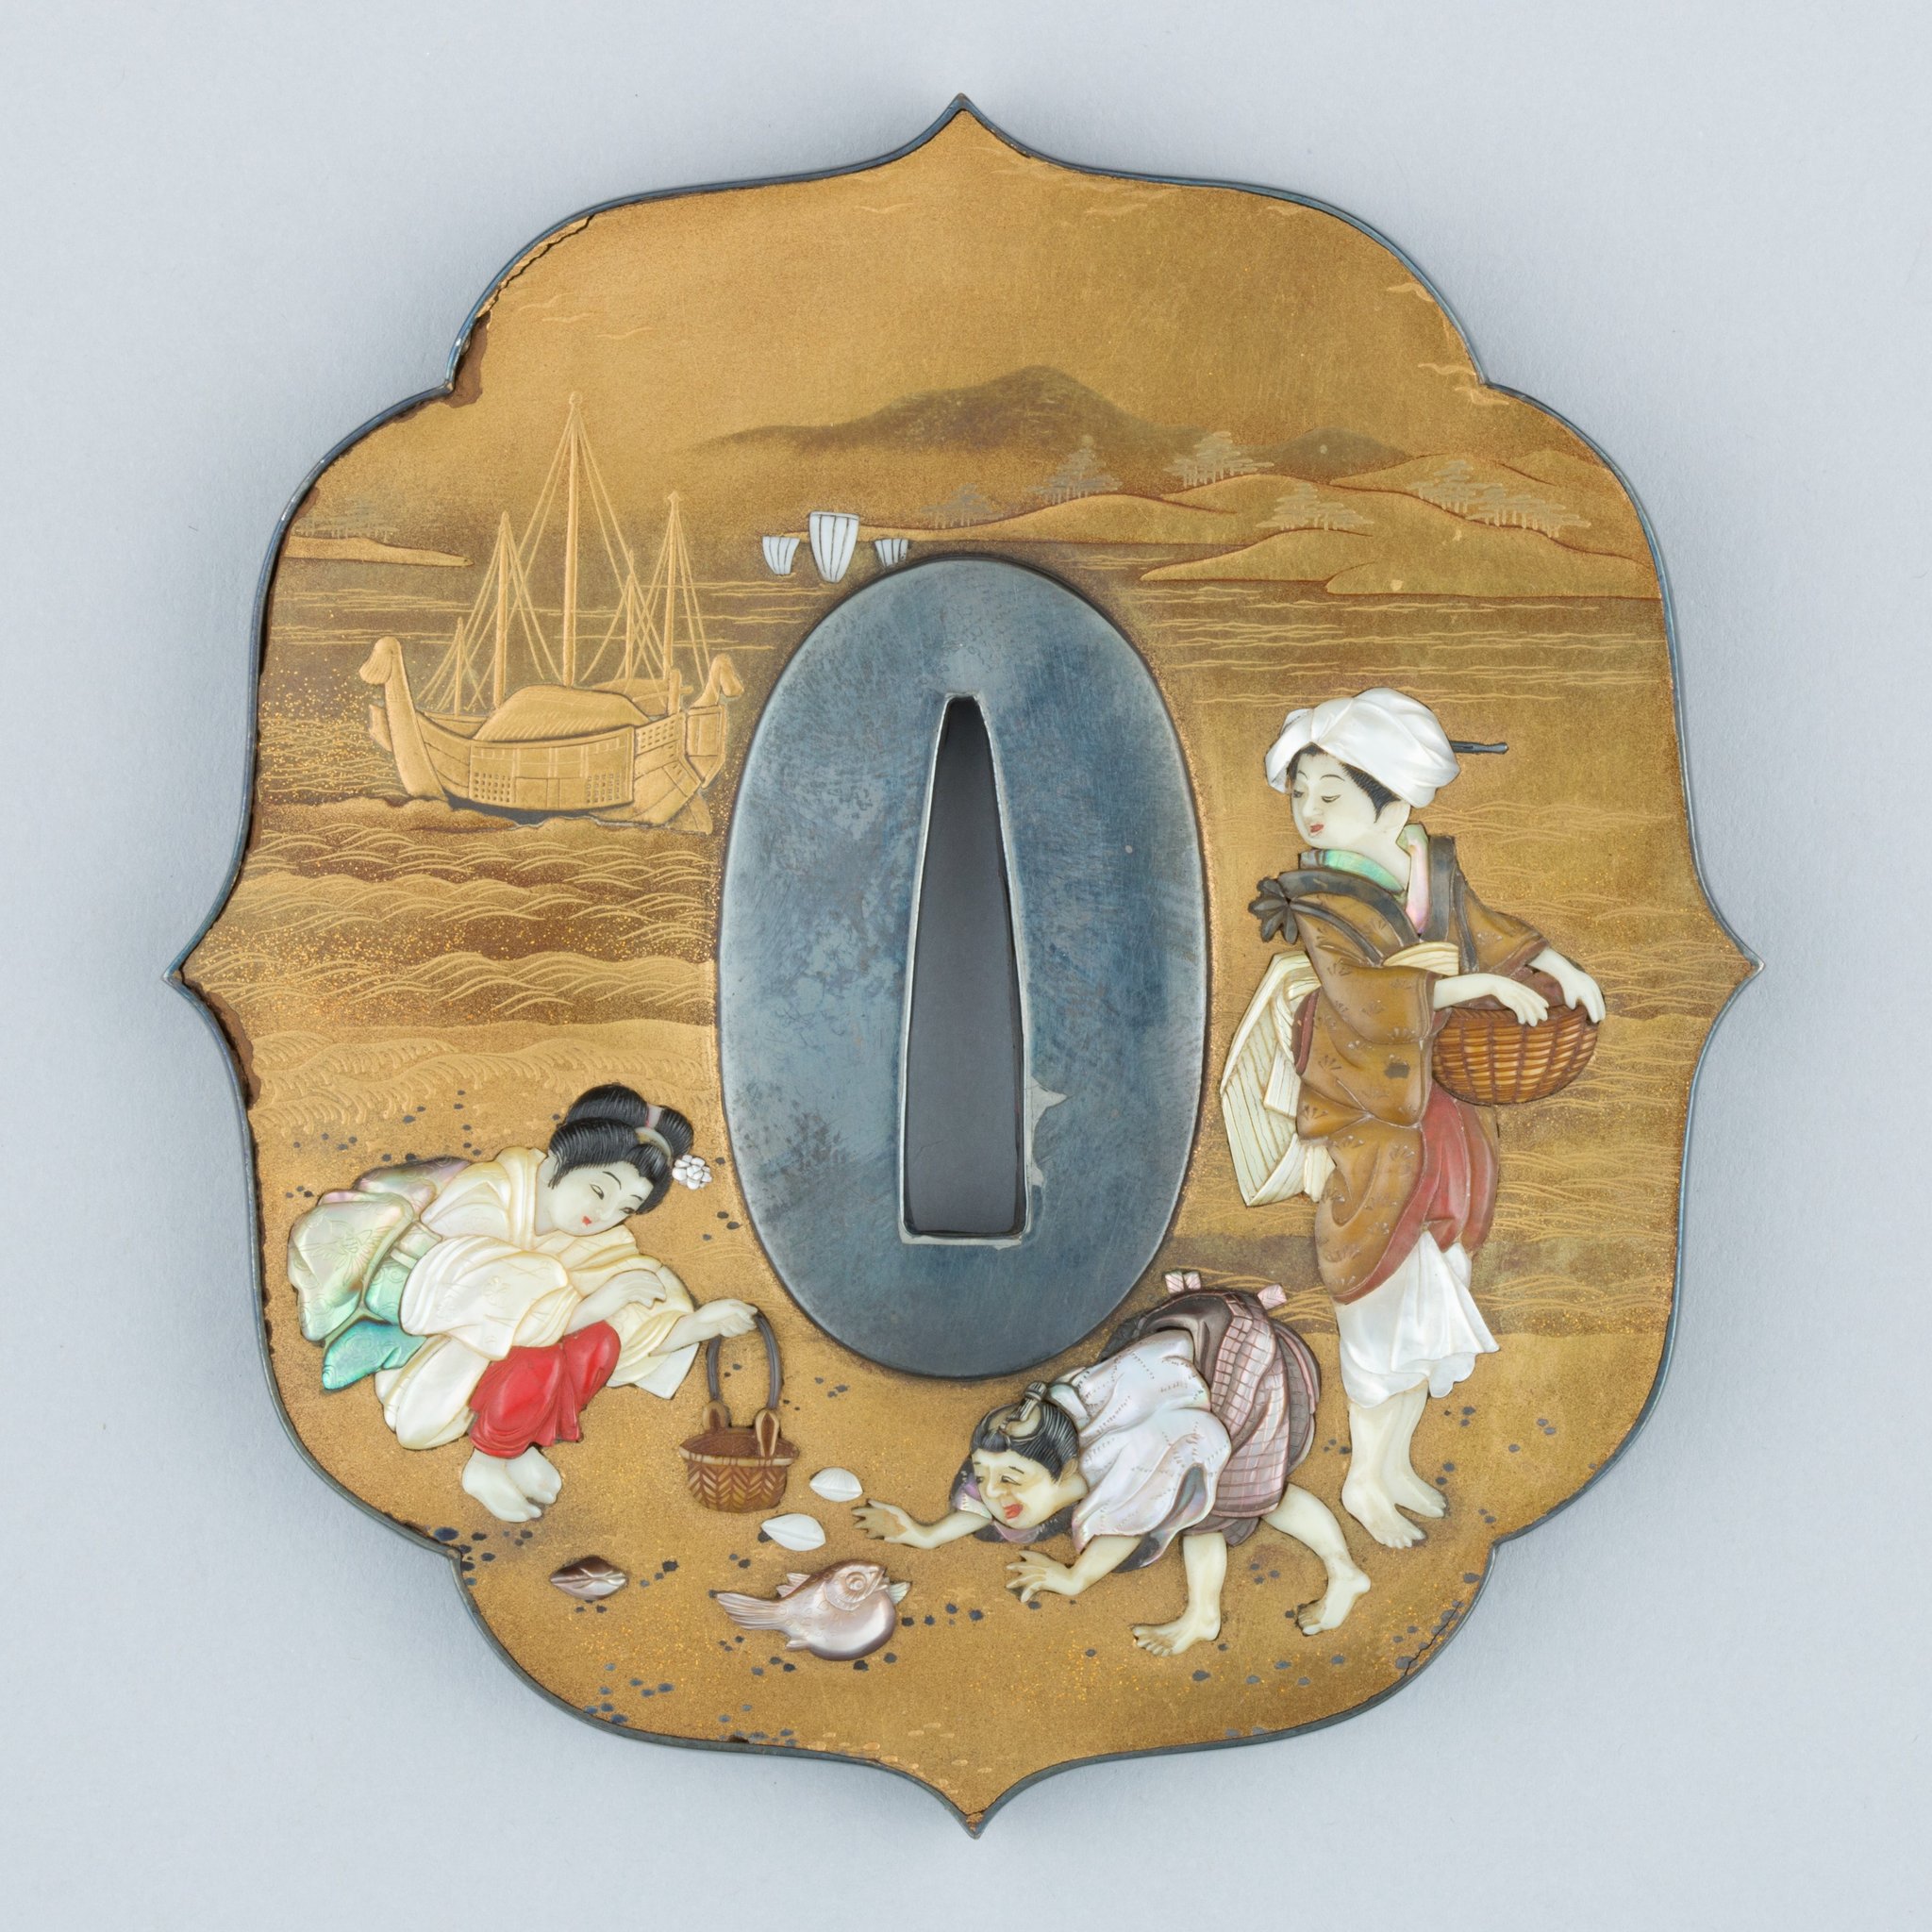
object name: sword guard tsuba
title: Sword Guard (Tsuba)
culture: japanese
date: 1701-1800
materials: stone, copper, coral, ivory, lacquer, mother of pearl, pewter, shell, wood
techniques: maki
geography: japan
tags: birds,women,fish,flowers,ships